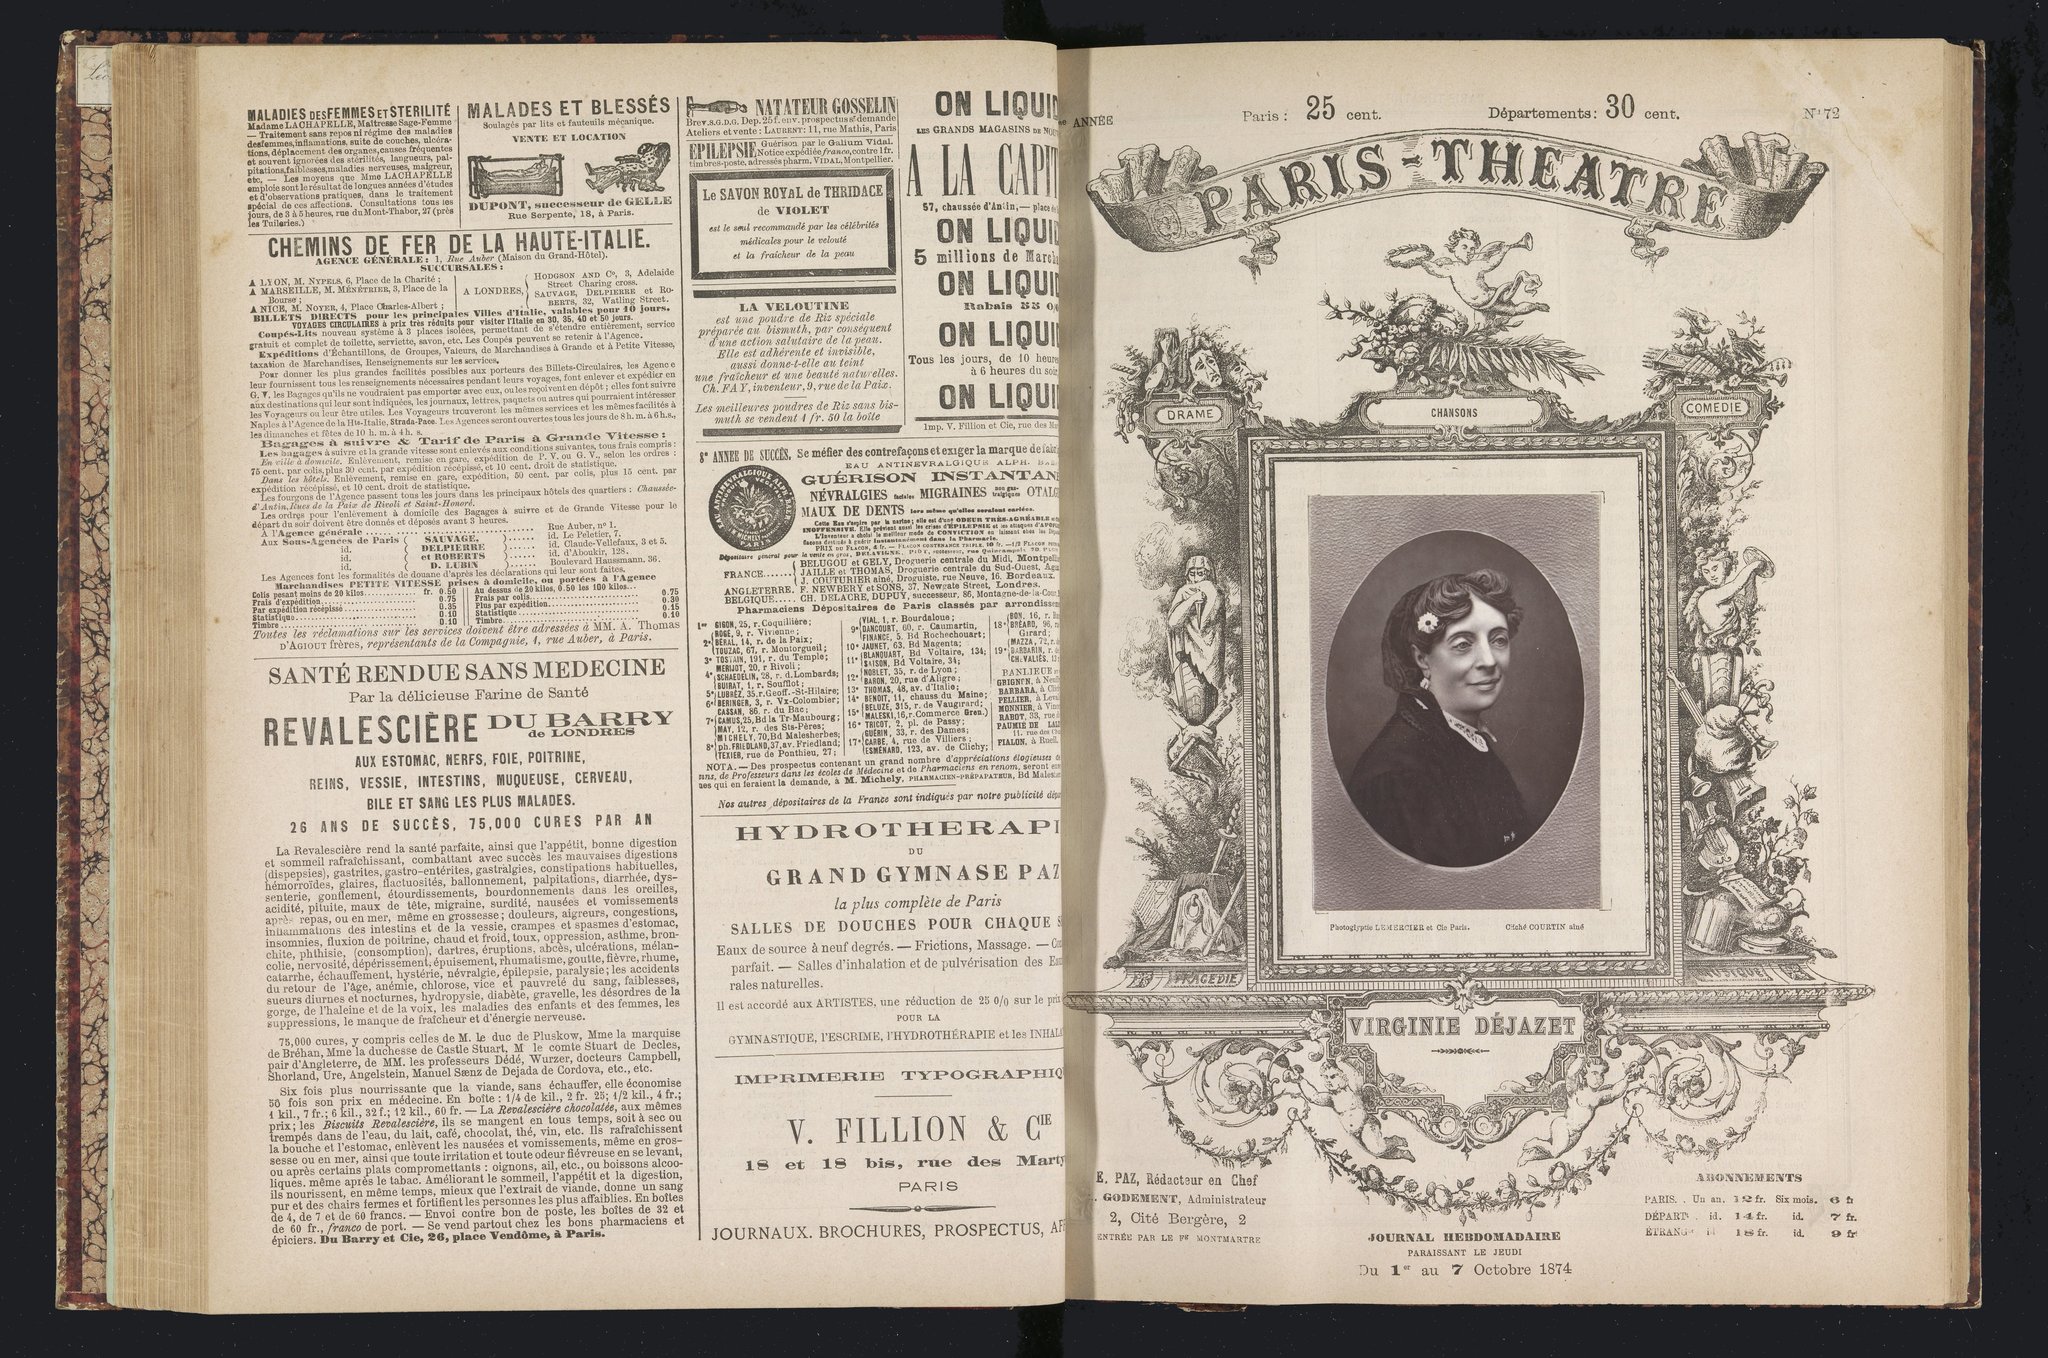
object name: photomechanical print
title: Portret van Virginie Déjazet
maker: j. tourtin (lainé)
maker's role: fotograaf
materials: paper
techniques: woodburytype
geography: france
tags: portrait of actor, actress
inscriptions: number: ‘No 72’, inscription: ‘Journal hebdomadaire paraissant le jeudi Du 1er au 7 Octobre 1874’